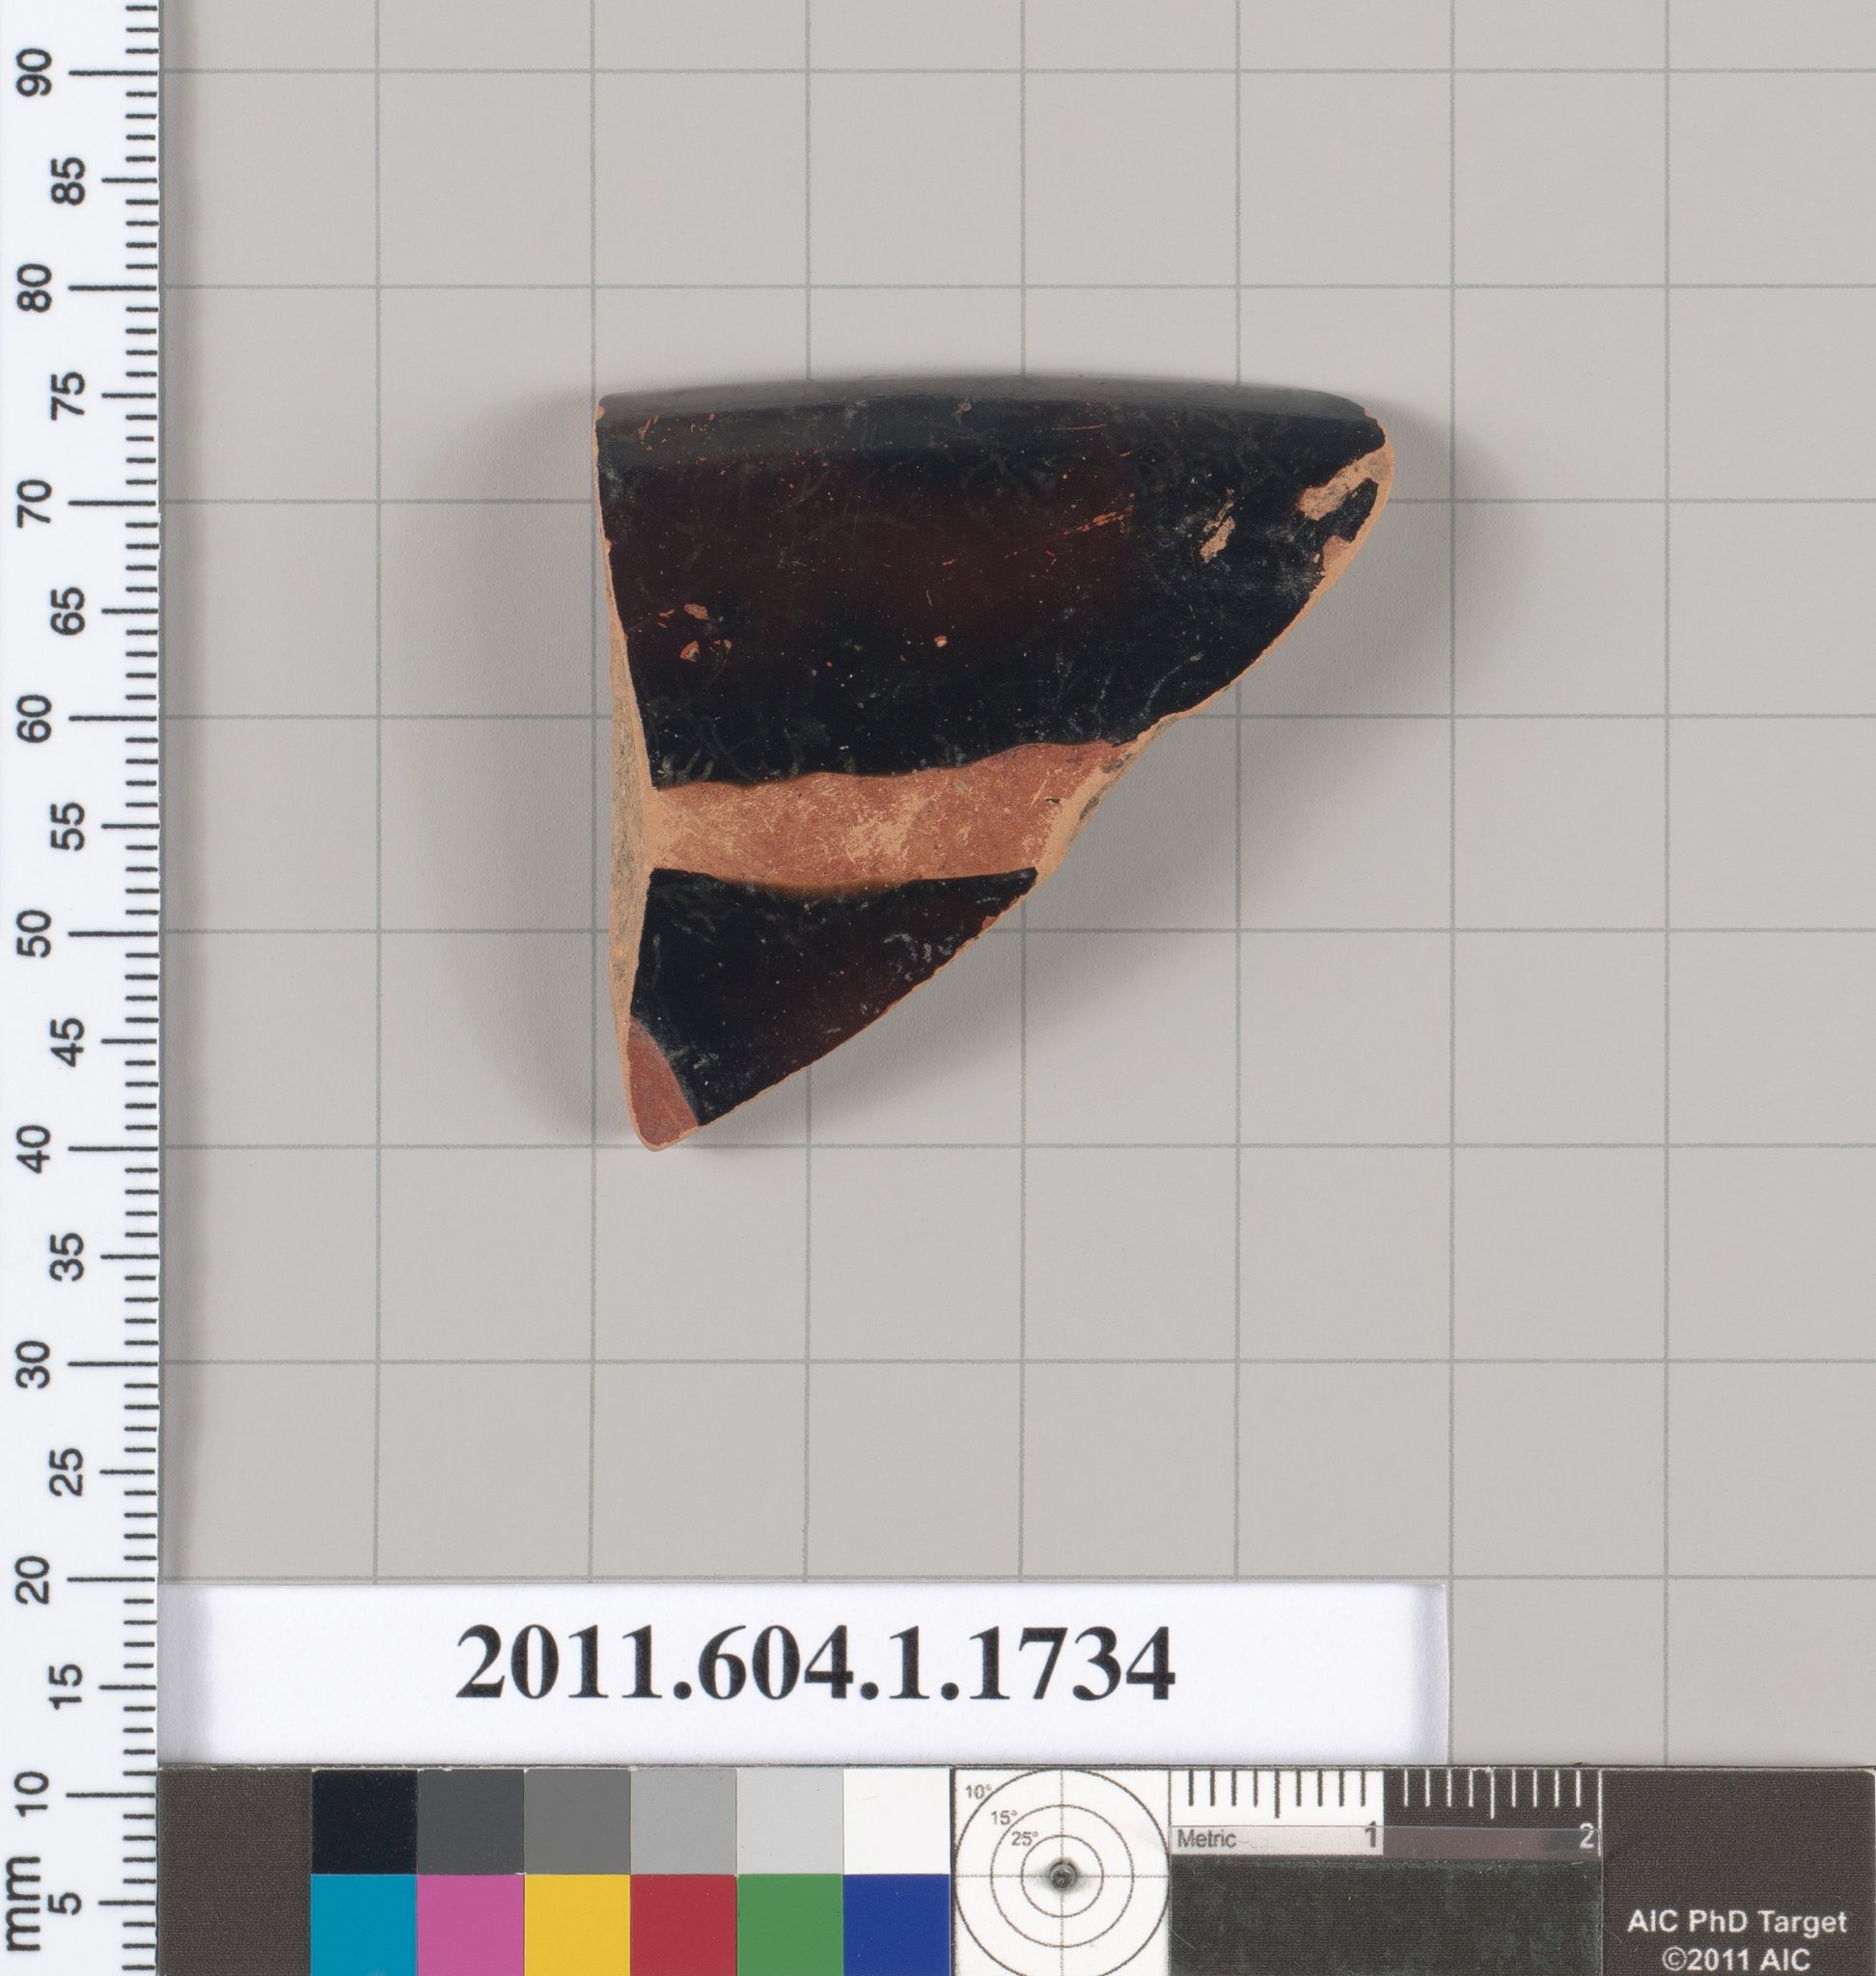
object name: kylix fragment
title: Terracotta rim fragment of a kylix (drinking cup)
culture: greek, attic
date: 475-451 BCE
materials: terracotta